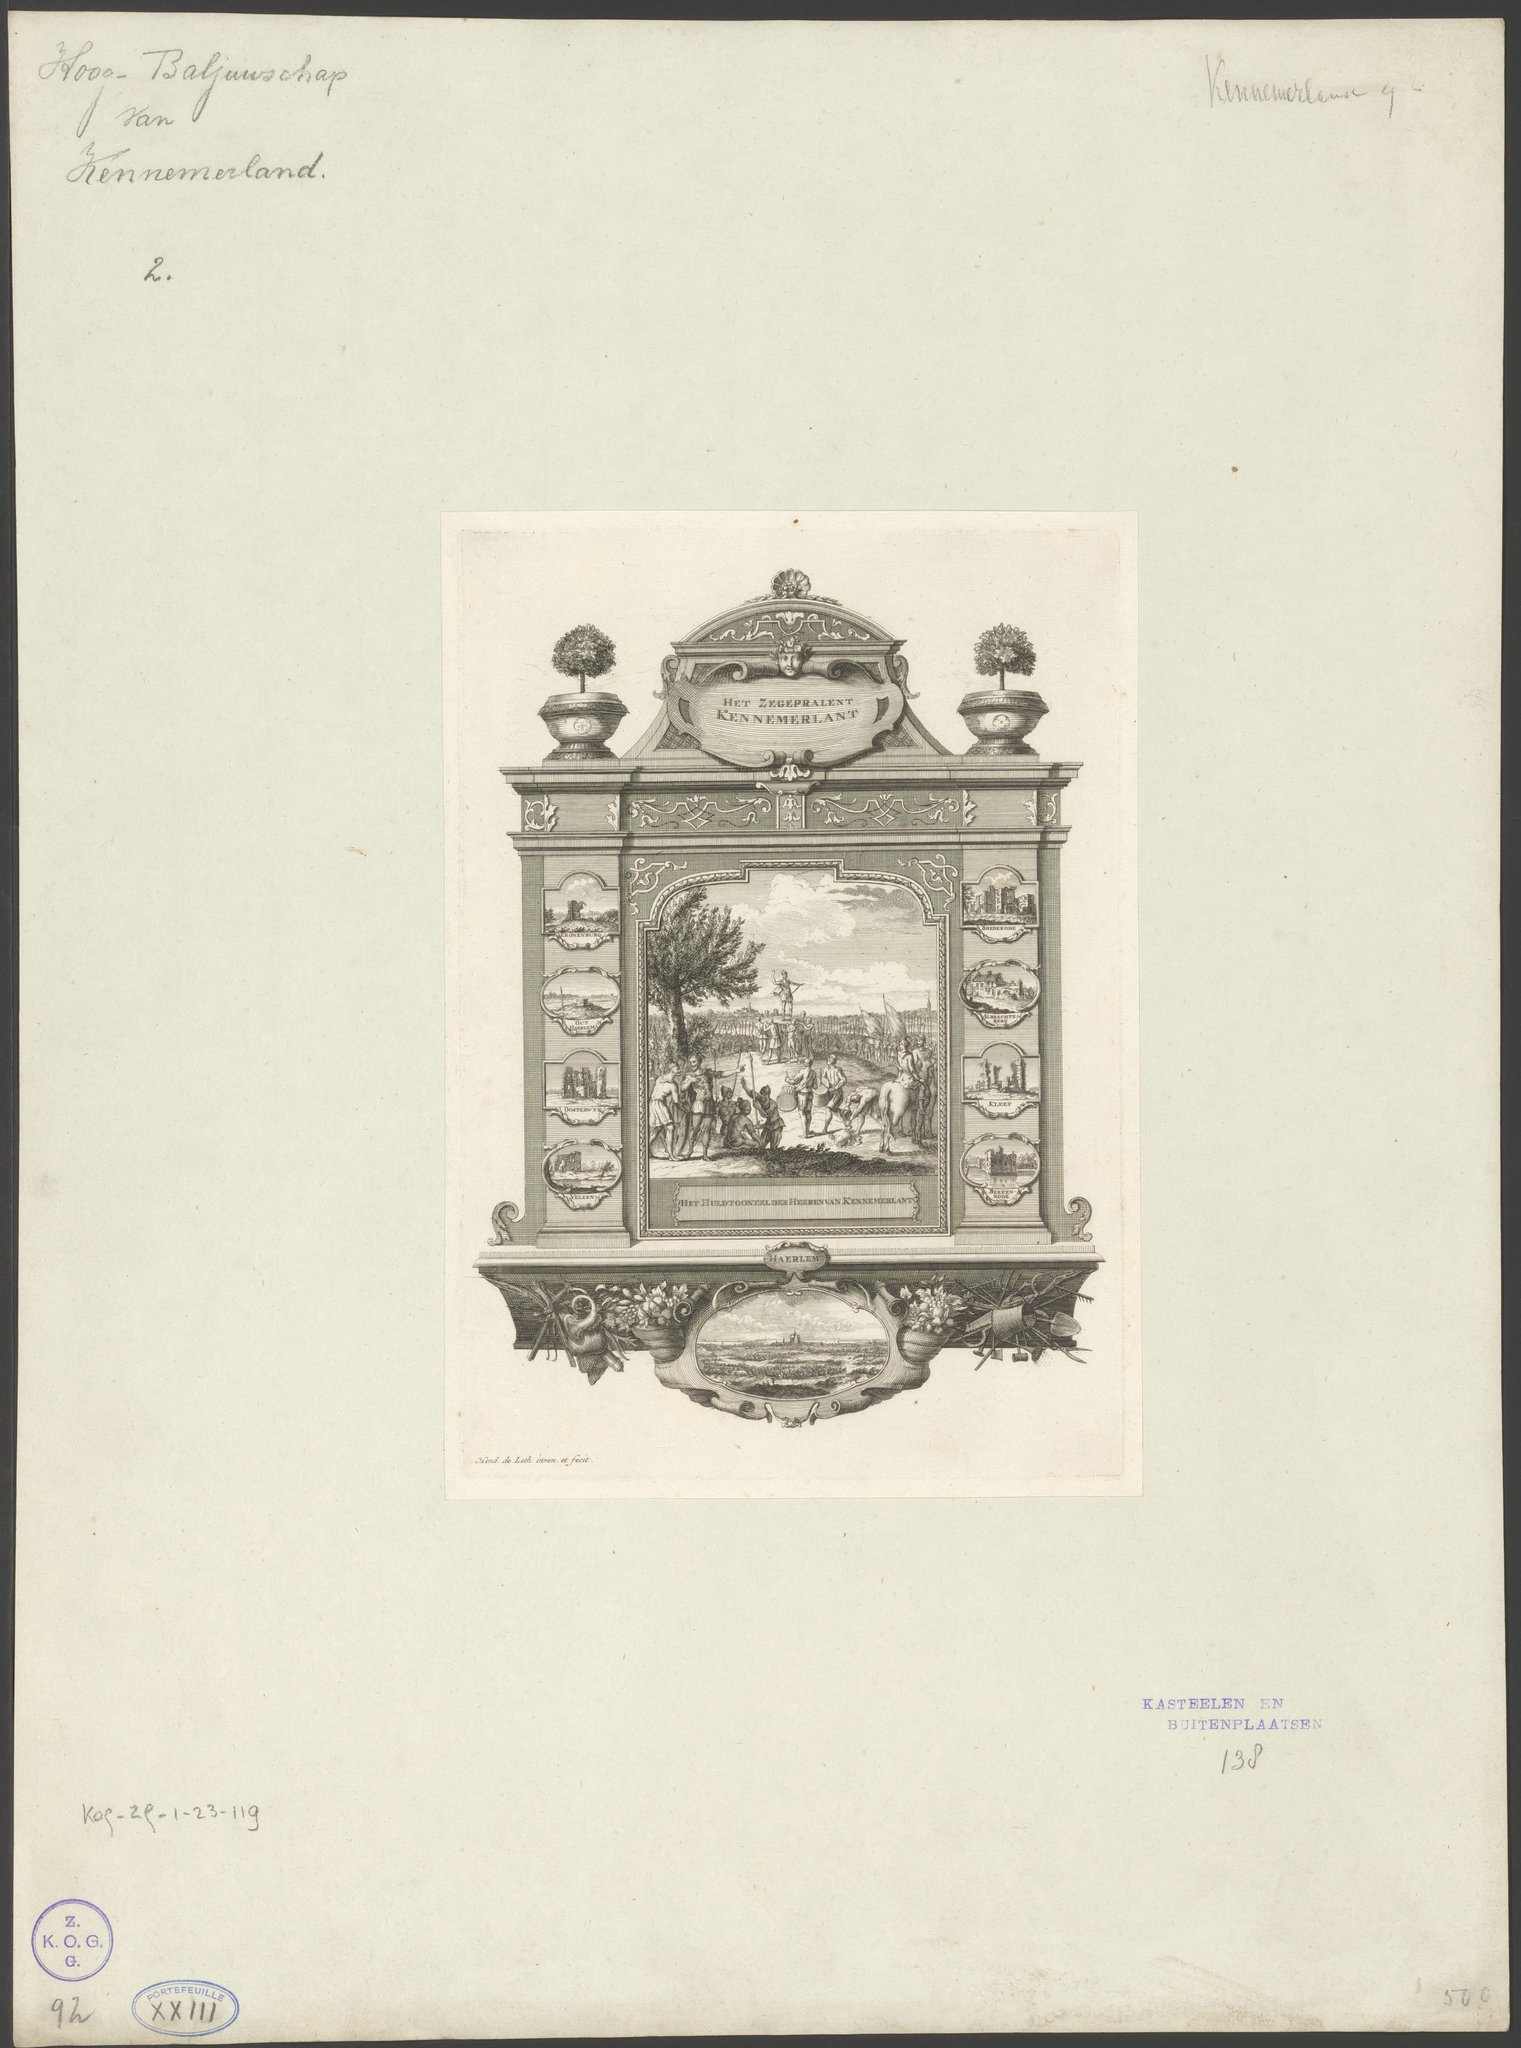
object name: titelprent, frontispice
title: Het Zegepralent Kennemerlant, Het Huldetooneel der Heeren van Kennemerklant, Tweede Deel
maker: hendrik de leth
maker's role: draughtsman, print maker, publisher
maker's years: 1703-1766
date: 1732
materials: paper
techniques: engraving, etching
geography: amsterdam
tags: brinio, castle, prospect of city, town panorama, silhouette of city, haarlem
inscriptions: collector's mark: Lugt 1641, stamp, stamp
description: Omlijsting met aan de bovenzijde de titel. In het midden een voorstelling van de huldiging van Cananefatenleider Brinio (staande op het schild) op het Huldtoneel of de Schepelenberg: Het Huldtooneel der Heeren van Kennemerlant. Links en rechts een pilaster met daarop afbeeldingen van (ruïnes van) kastelen uit Kennemerland. Onder een gezicht op Haarlem. Onderwerpsrubrieken binnen de Atlas Zeden en Gewoonten: Zeden en Gewoonten in Engeren Zin, De Woning. Kastelen en buitenplaatsen. Holland (vervolg.)